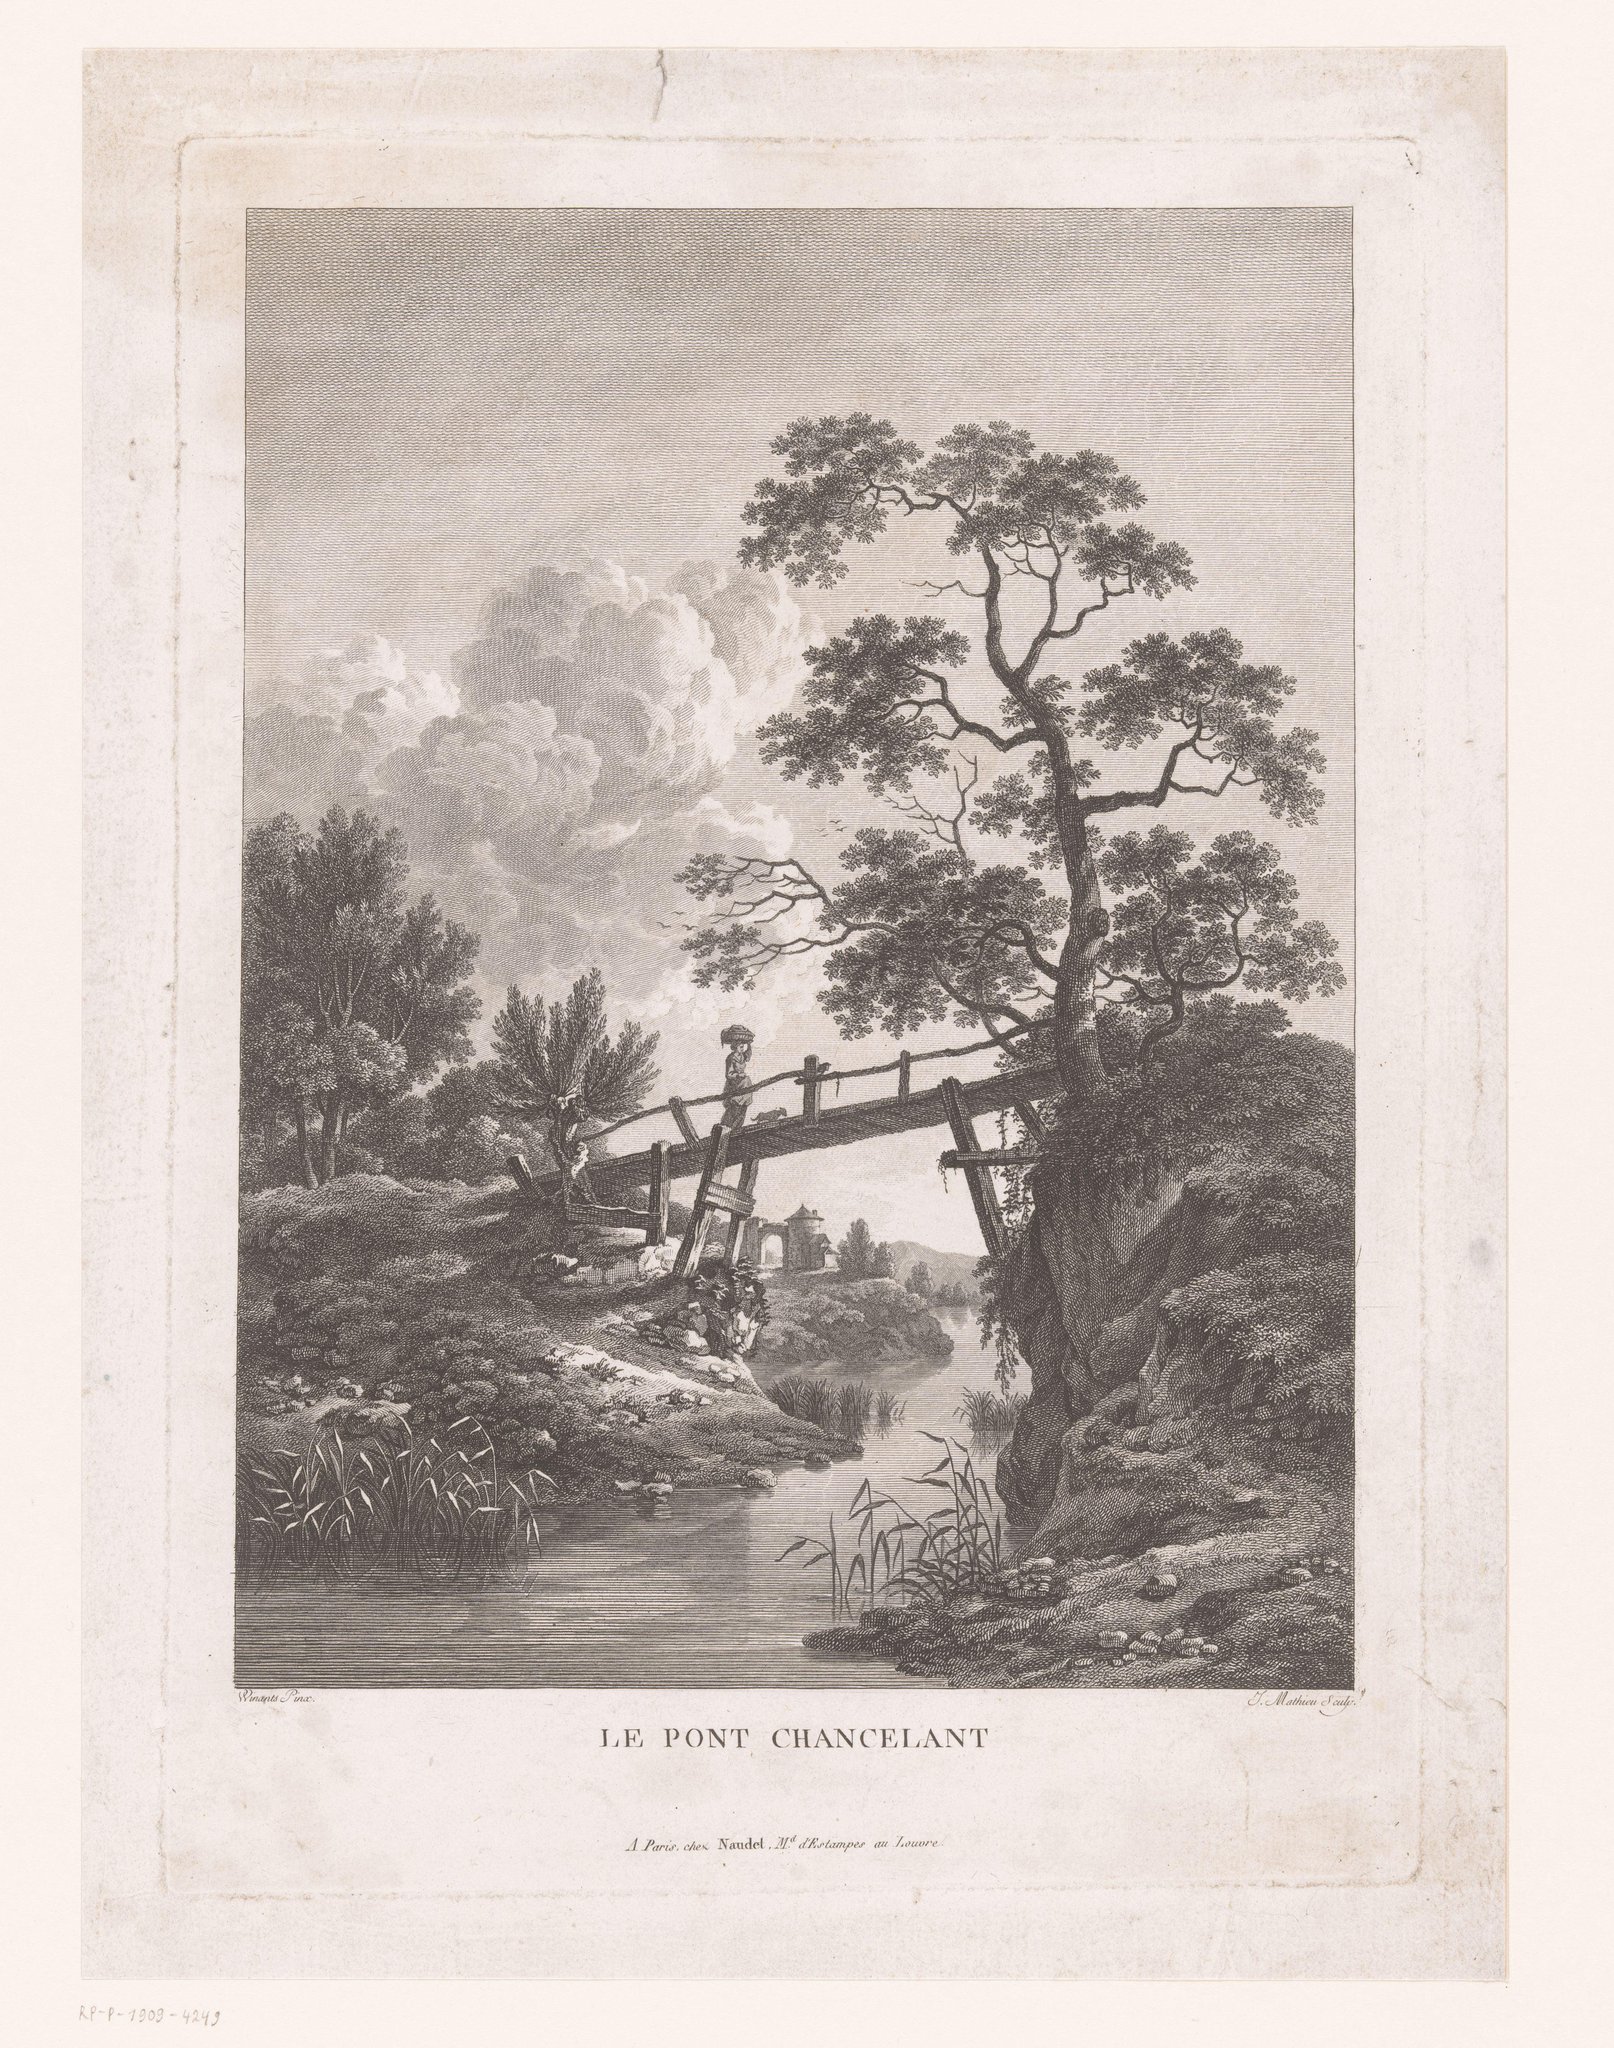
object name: print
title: Vrouw met mand op houten brug over een rivier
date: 1759-1815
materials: paper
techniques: engraving, etching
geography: paris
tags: water course, bridge, carrying something on the head or on the shoulders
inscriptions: collector's mark: Lugt 2228